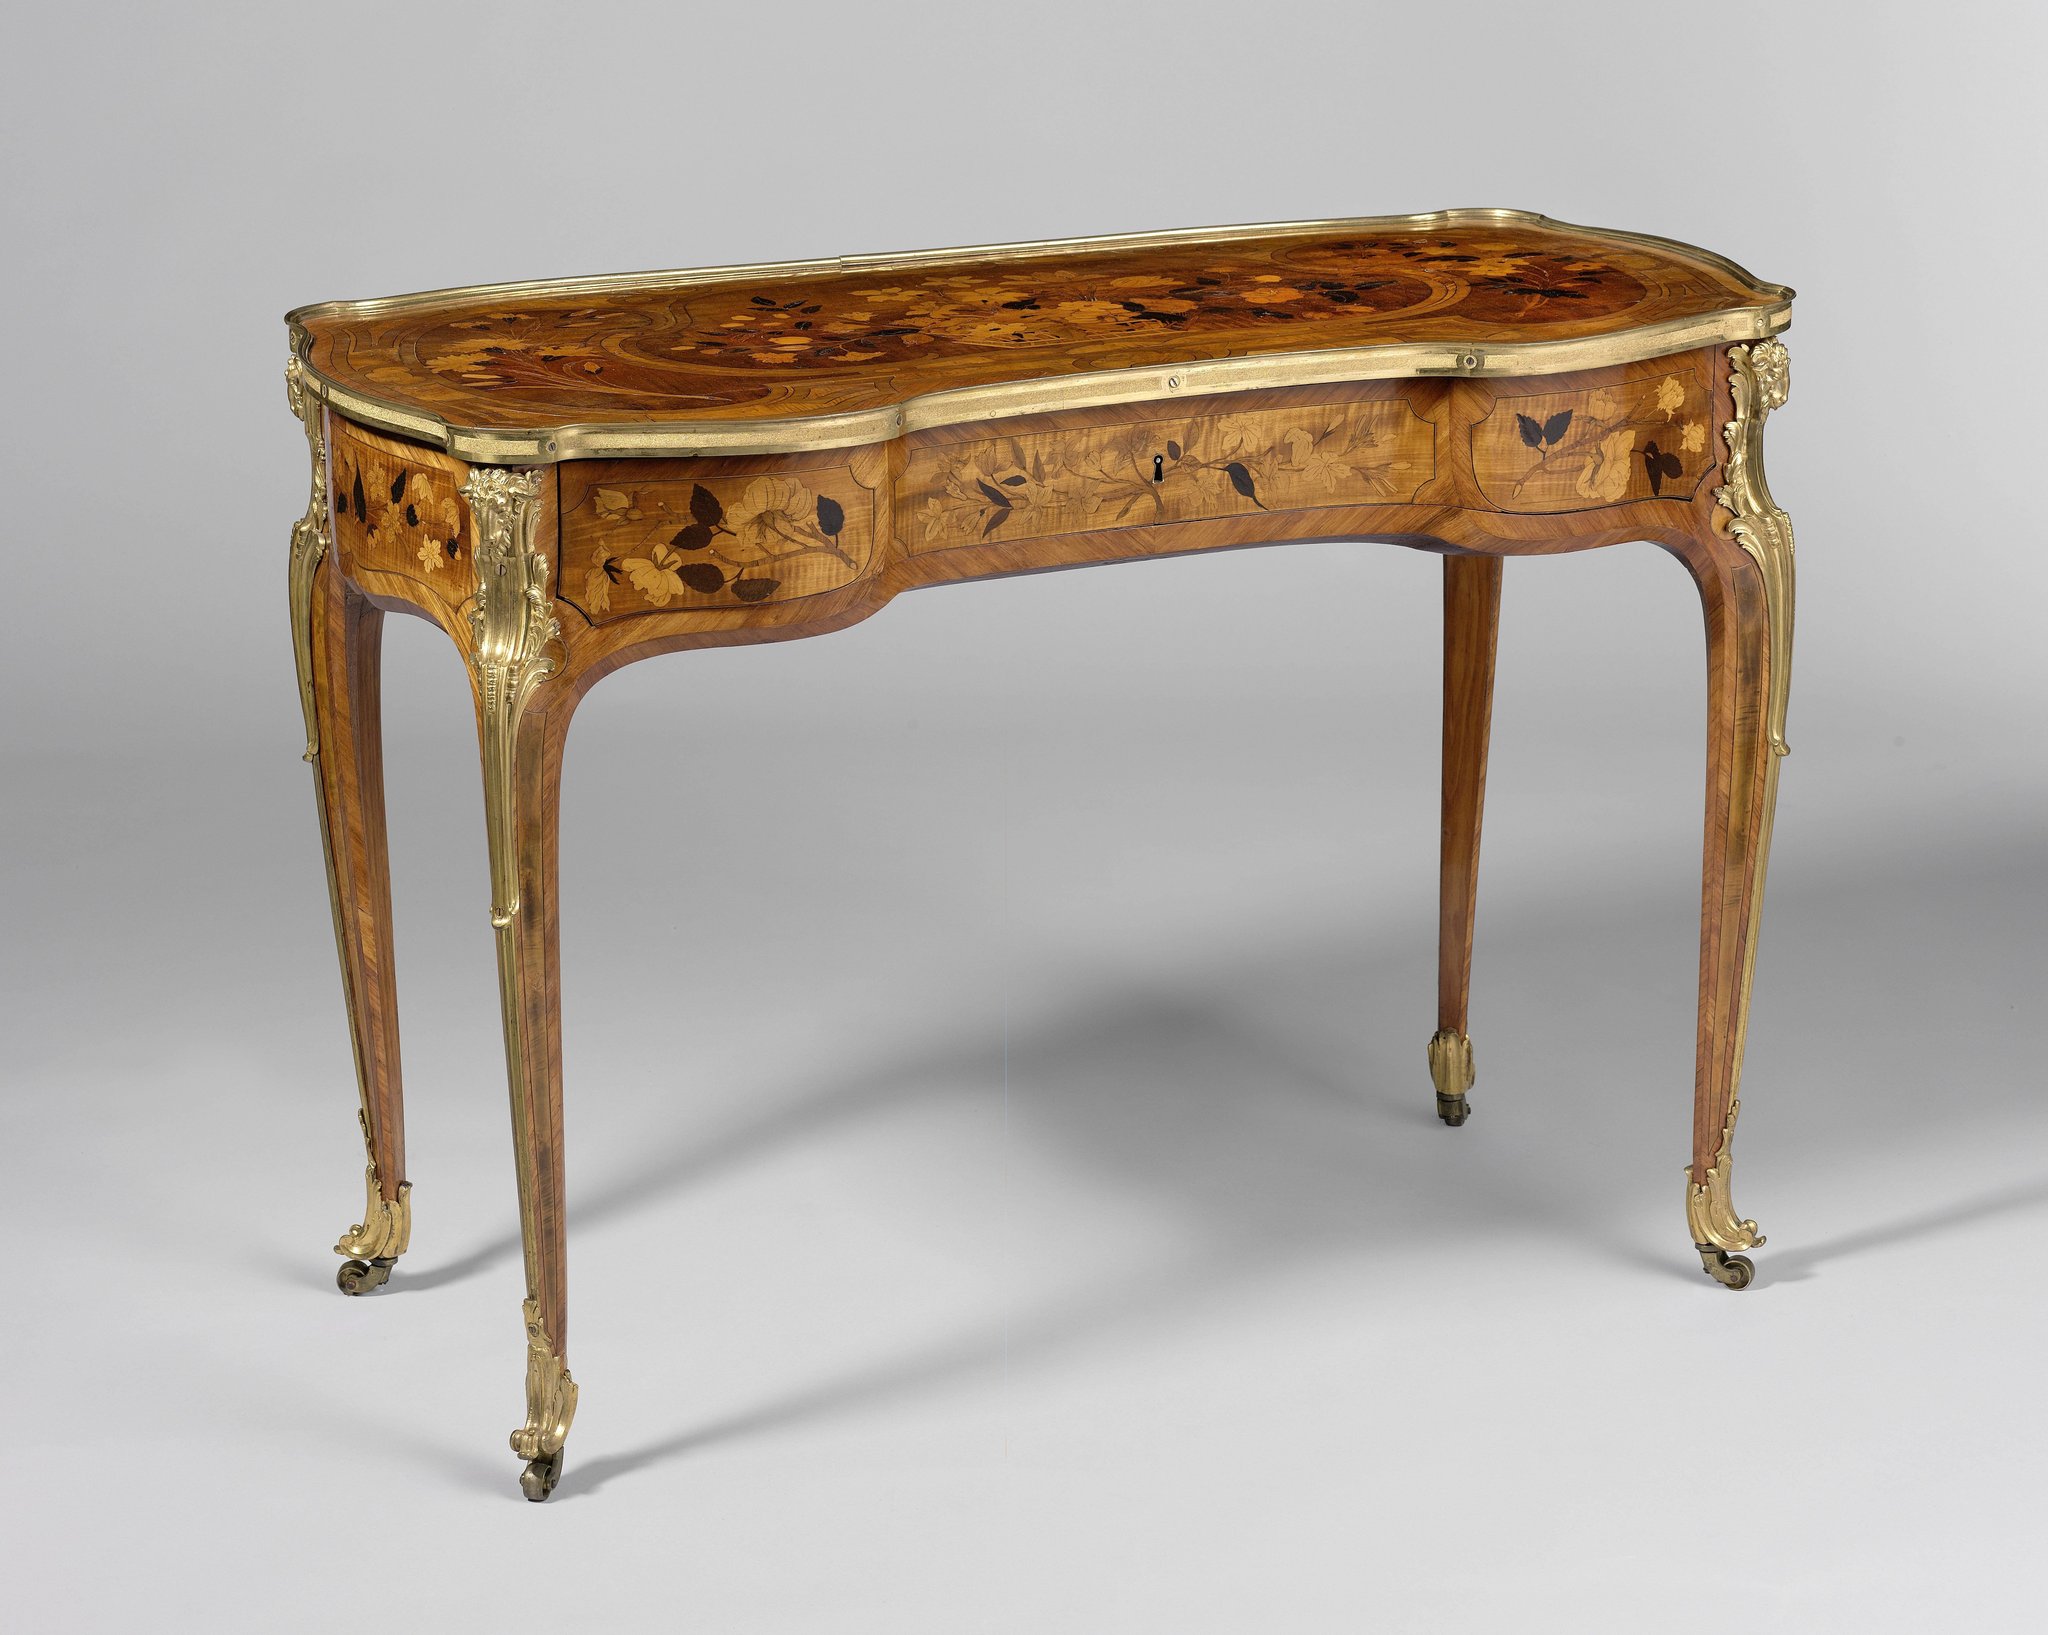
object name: furniture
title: Writing table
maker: jean françois oeben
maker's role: furniture worker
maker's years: 1710-1763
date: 1760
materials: bronze, wood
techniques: gilding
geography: paris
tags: flowers ~ ornament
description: Oeben, originally from Germany, specialized in furniture with complicated mechanical parts. When the surface of this desk is pushed back, the inner compartment with a writing panel slides forward. Oeben was also renowned for his delicate floral marquetry.